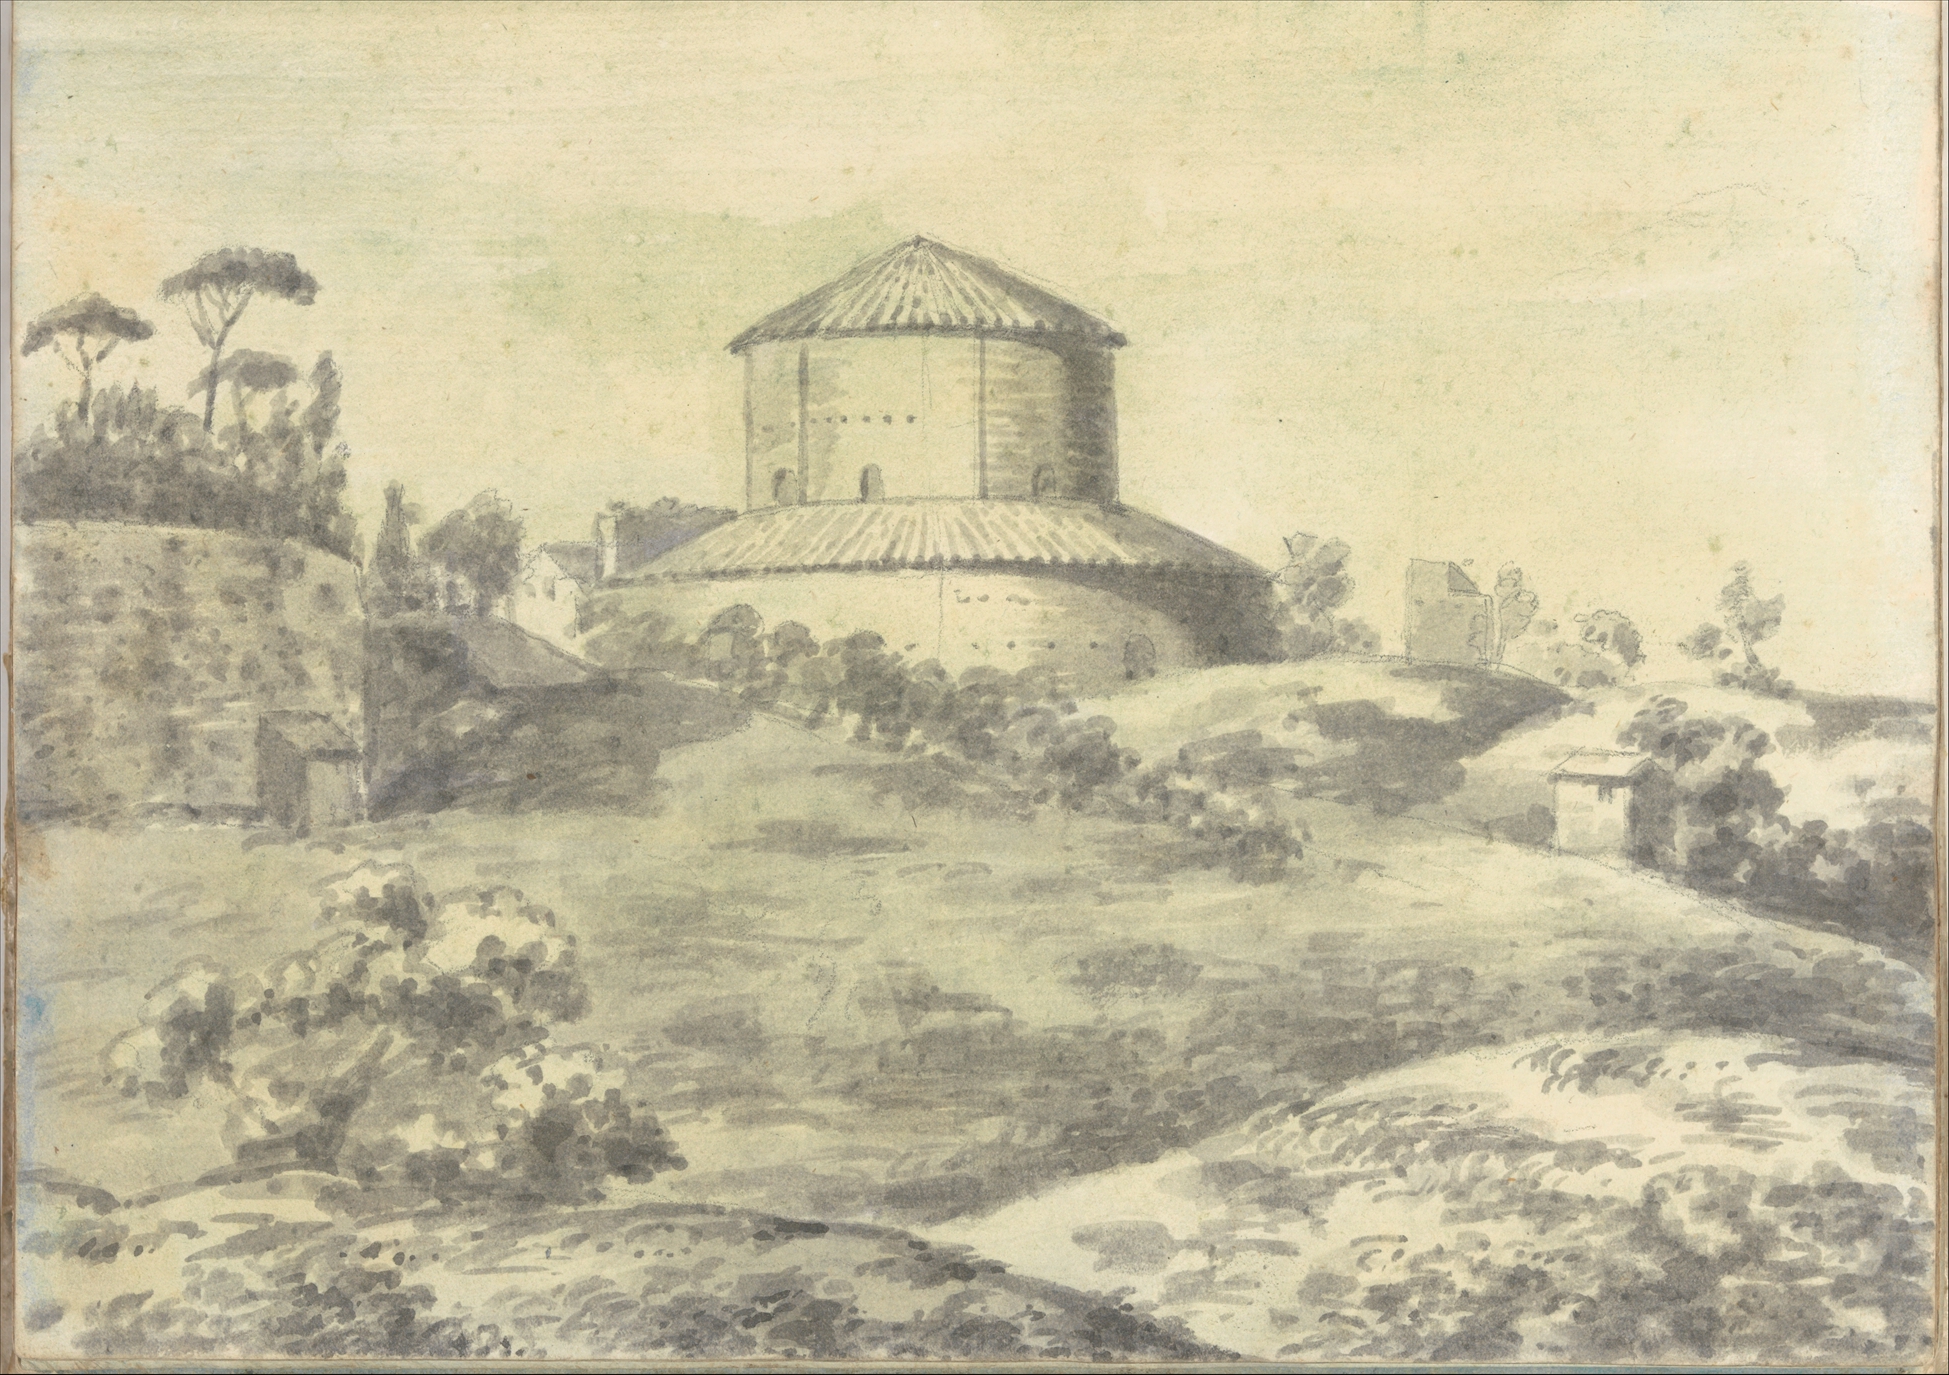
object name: drawing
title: Landscape with an ancient temple converted into a church, at Rome (Smaller Italian sketchbook, leaf 4 recto)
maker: joseph wright (wright of derby)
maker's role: artist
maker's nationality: british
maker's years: 1734-1797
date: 1774-1775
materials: ink, watercolor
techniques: brush, wash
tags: houses,landscapes